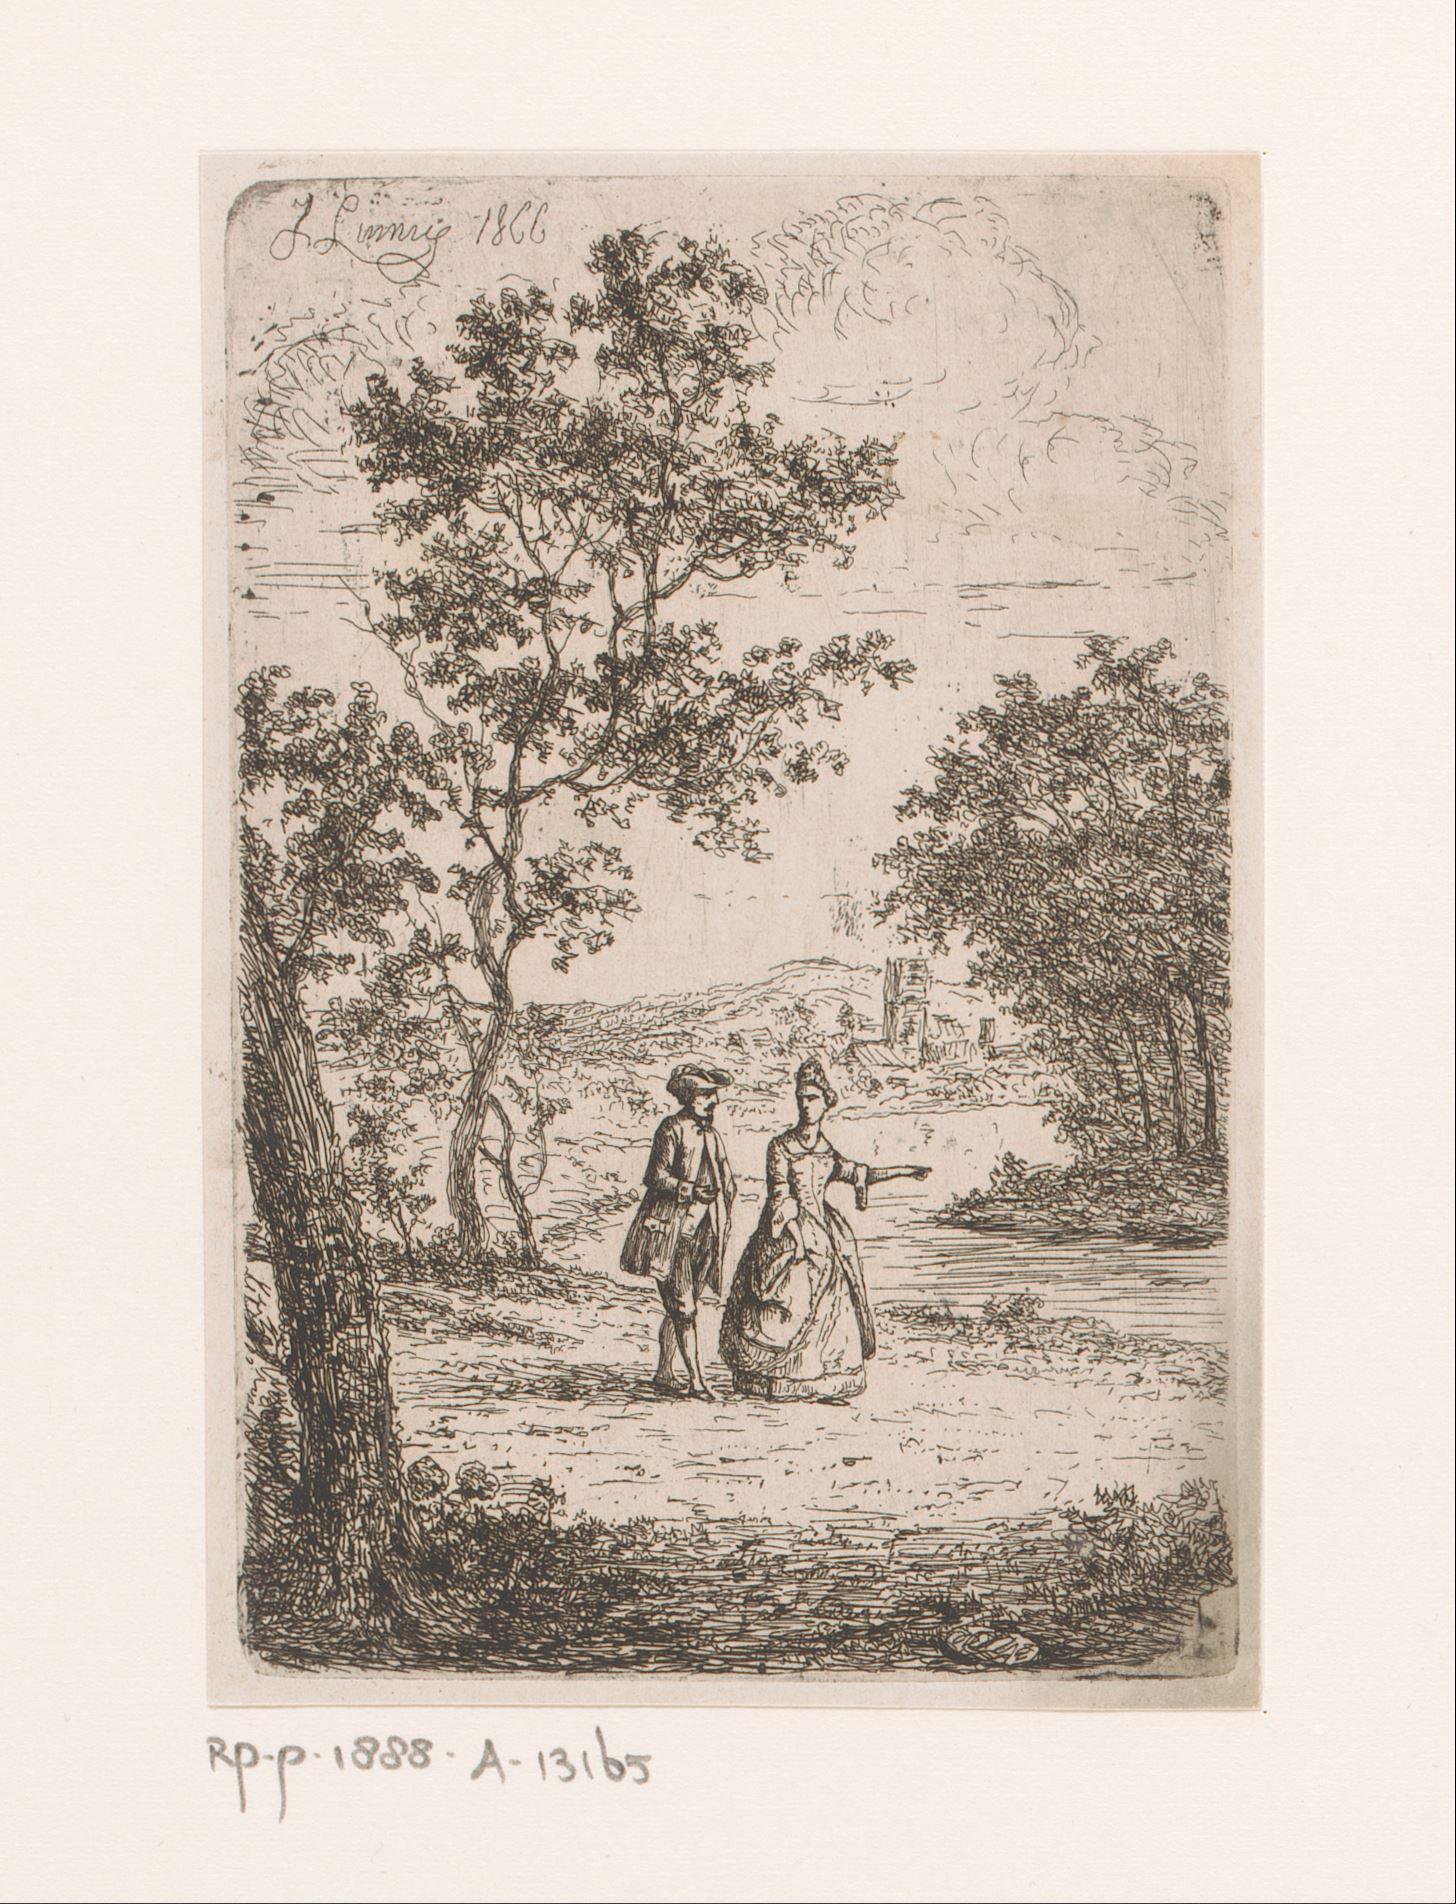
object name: print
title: Paar wandelt langs het water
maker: jean théodore joseph linnig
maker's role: draughtsman, print maker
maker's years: 1815-1891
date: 1866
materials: paper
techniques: etching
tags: couple of lovers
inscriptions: collector's mark: Lugt 2228